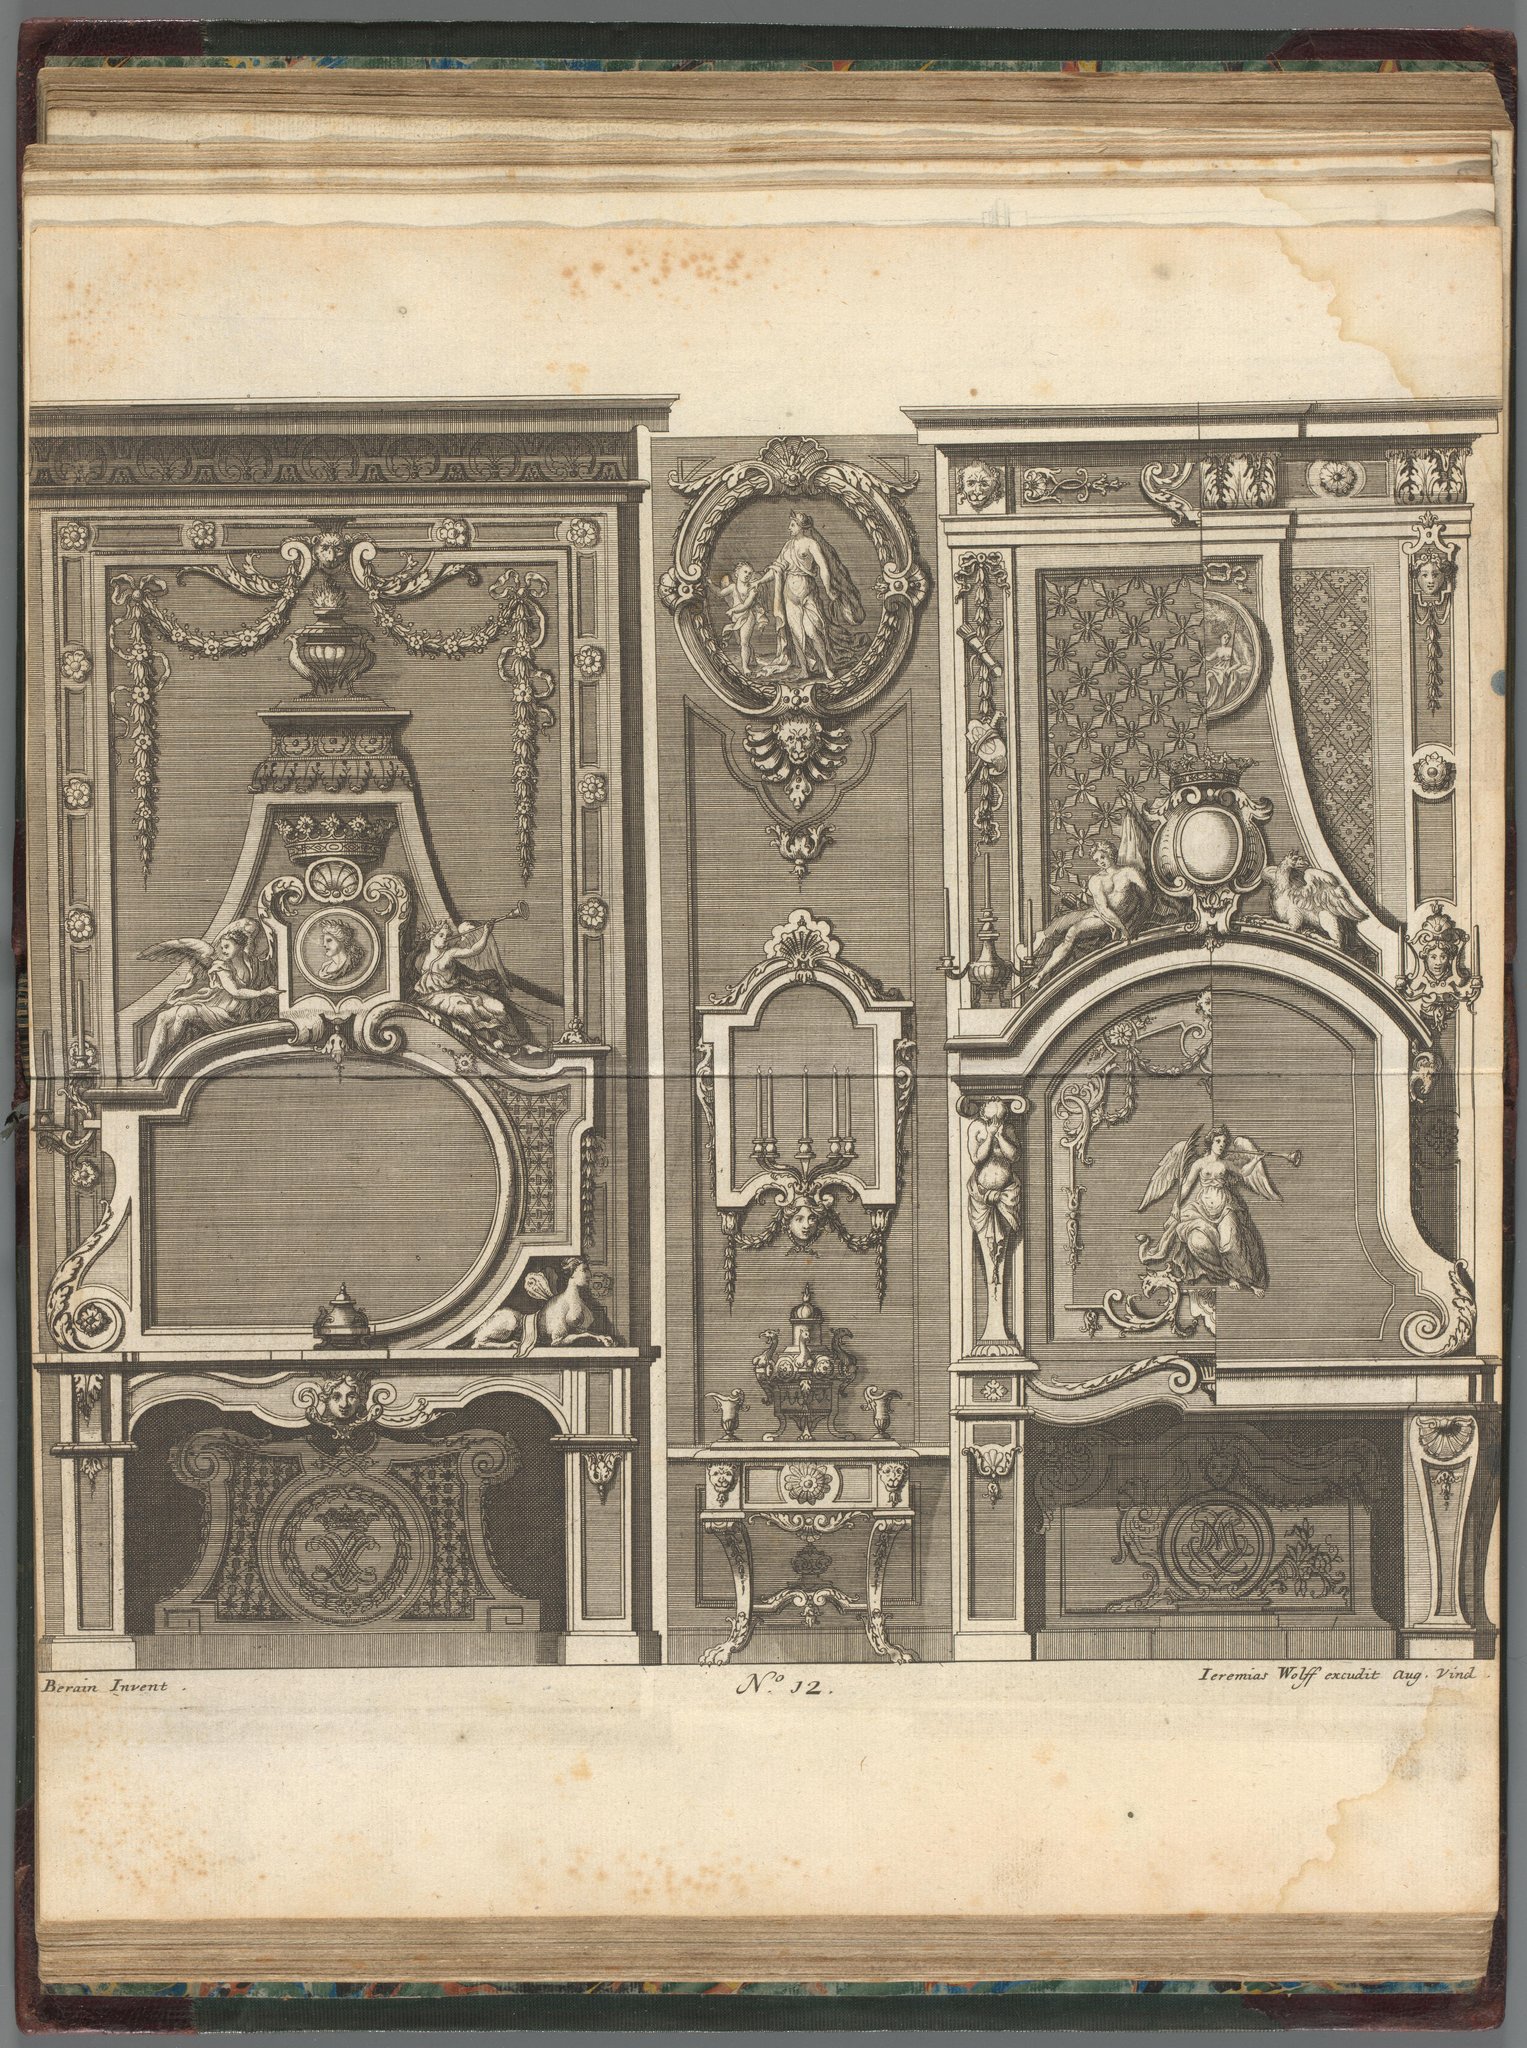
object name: print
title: Haarden met engelen blazend op bazuinen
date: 1686-1724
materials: paper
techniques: etching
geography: augsburg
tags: ornaments ~ art, fire-screen, open hearth, fire-place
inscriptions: signature: ‘Ieremias Wolff excudit Aug. Vind.’, number: ‘No. 12’, signature: ‘Berain Invent’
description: Twee geornamenteerde haarden. Links met een medaillon met een portret en profil geflankeerd door twee engelen waarvan een op een bazuin blaast, onderaan een haardplaat. Rechts met een engel blazend op een bazuin en een paltak in de hand, een leeg heraldisch schild met een kroon erboven, een griffioen en onderaan een haardplaat. De haarden flankeren een paneel met bovenaan een ovaal met Venus en Amor, in het midden een omlijste kandelaar en onderaan een tafel met daarop vazen. Prent maakt deel uit van een album. Hoogstwaarschijnlijk gespiegelde kopie naar Frans origineel.